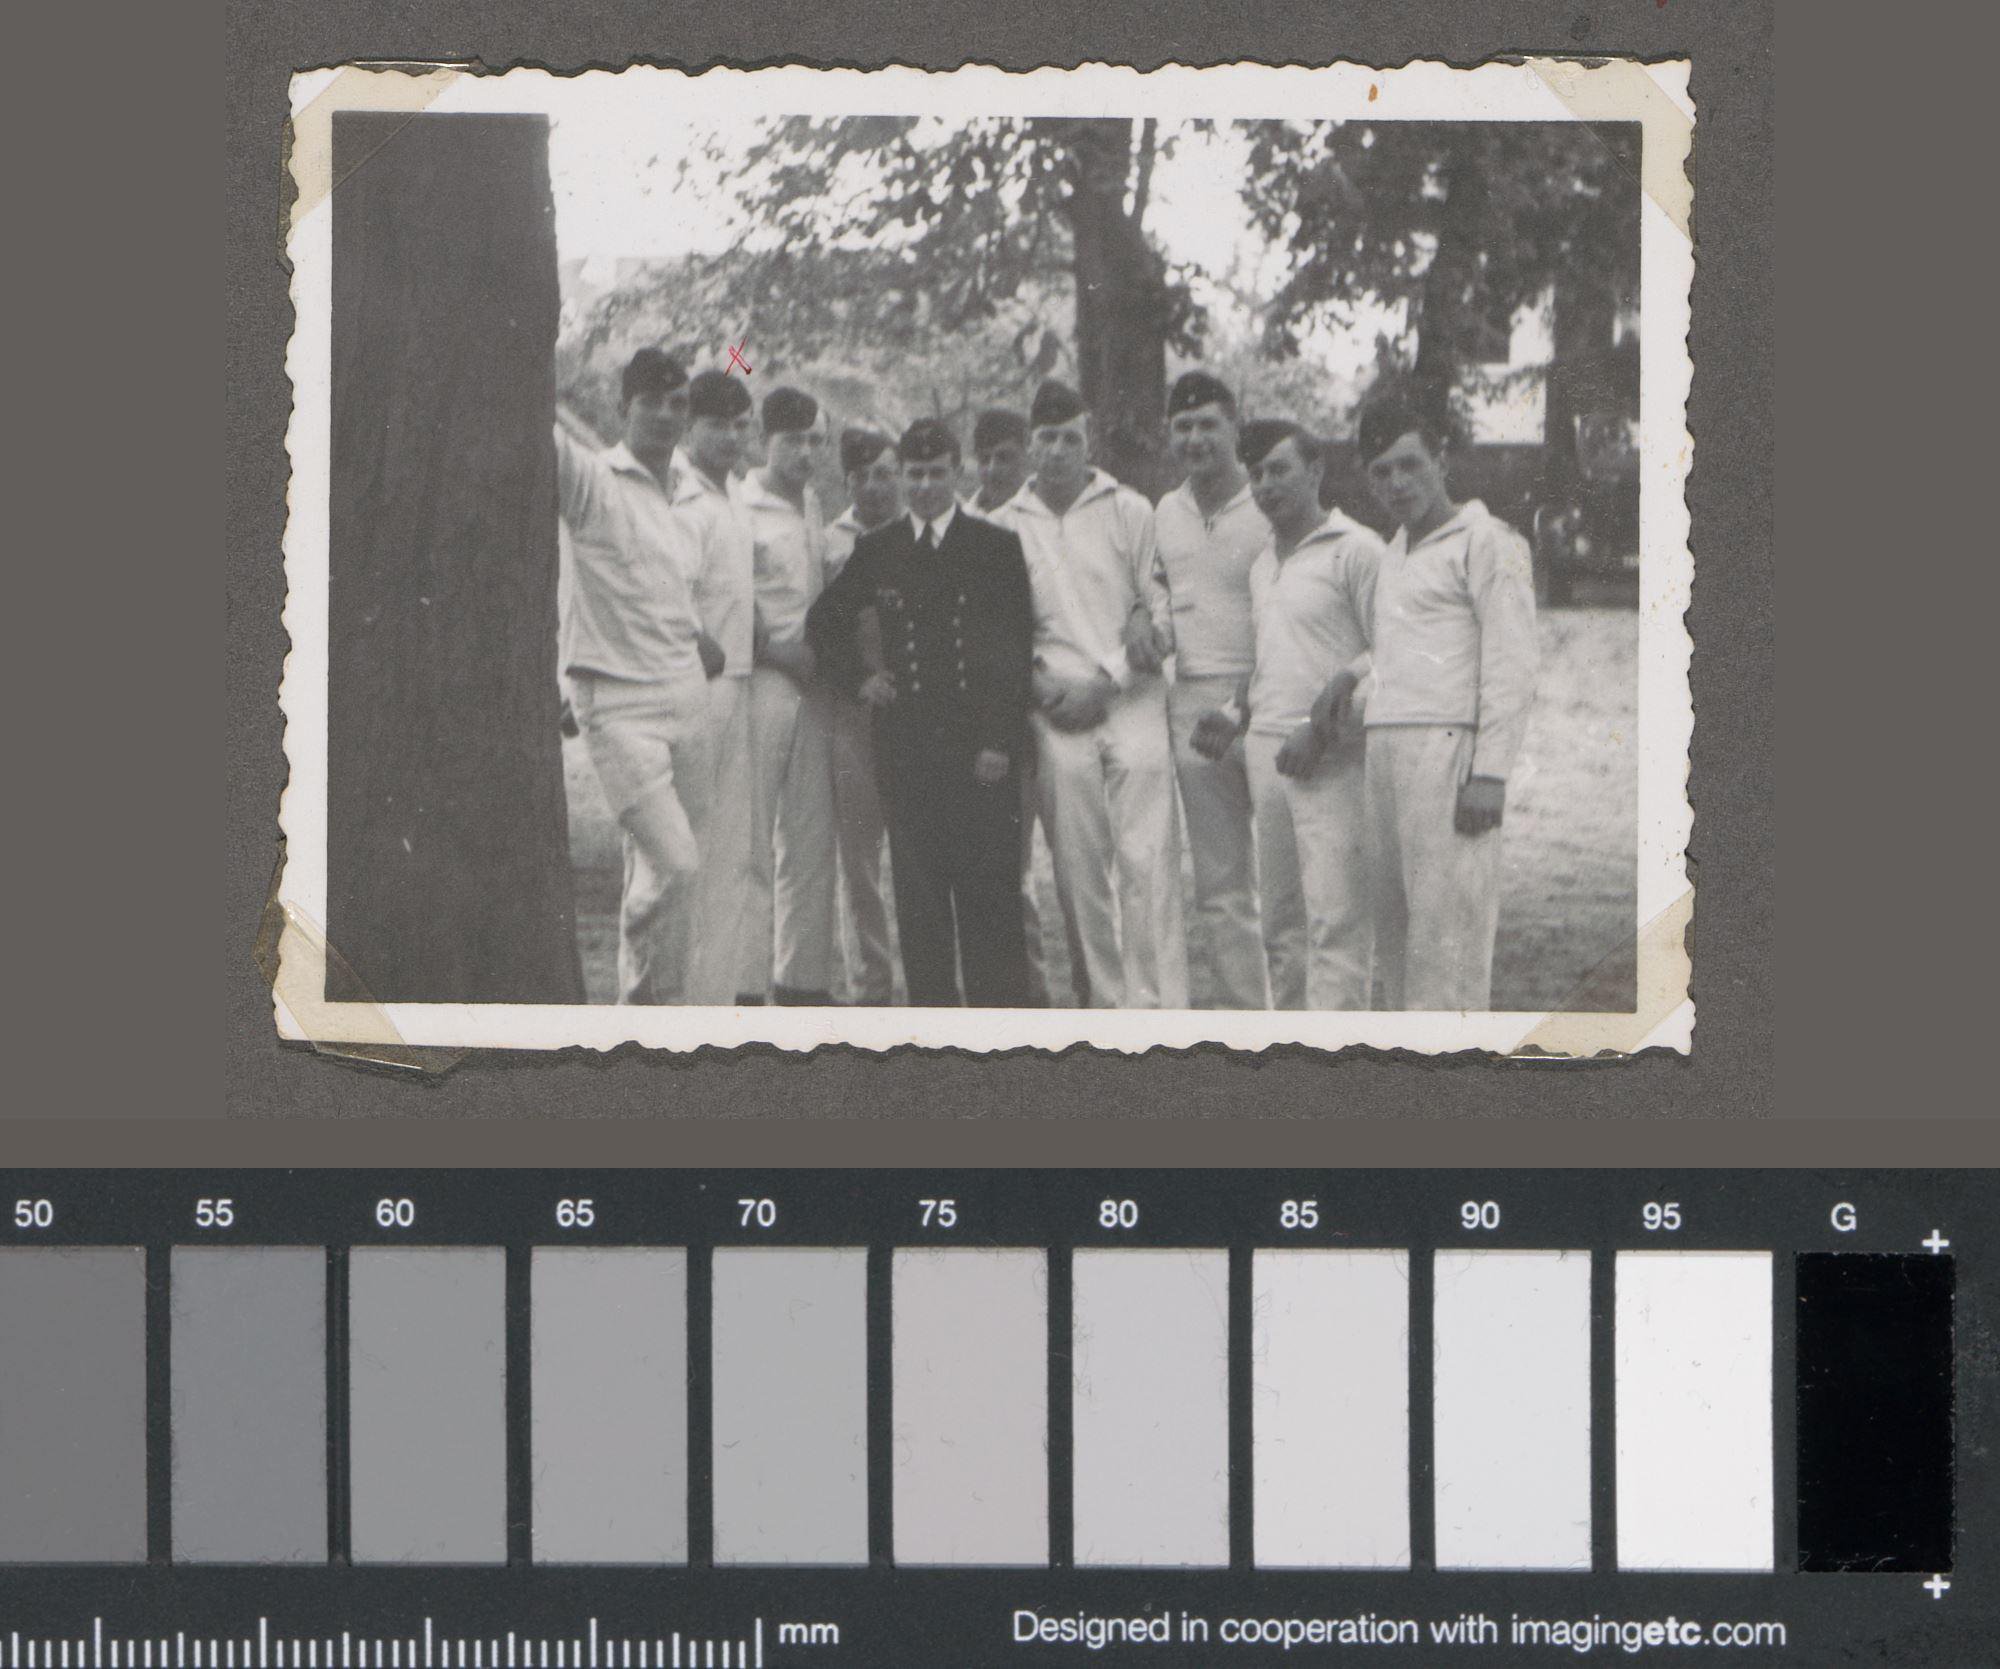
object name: album leaf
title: Die Kuttermannschaft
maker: Anonymous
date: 1941-1945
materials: paper, photographic support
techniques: gelatin silver print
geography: netherlands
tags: adult man, historical persons, occupation ~ war, netherlands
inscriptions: annotation: ‘Kutterpullen’